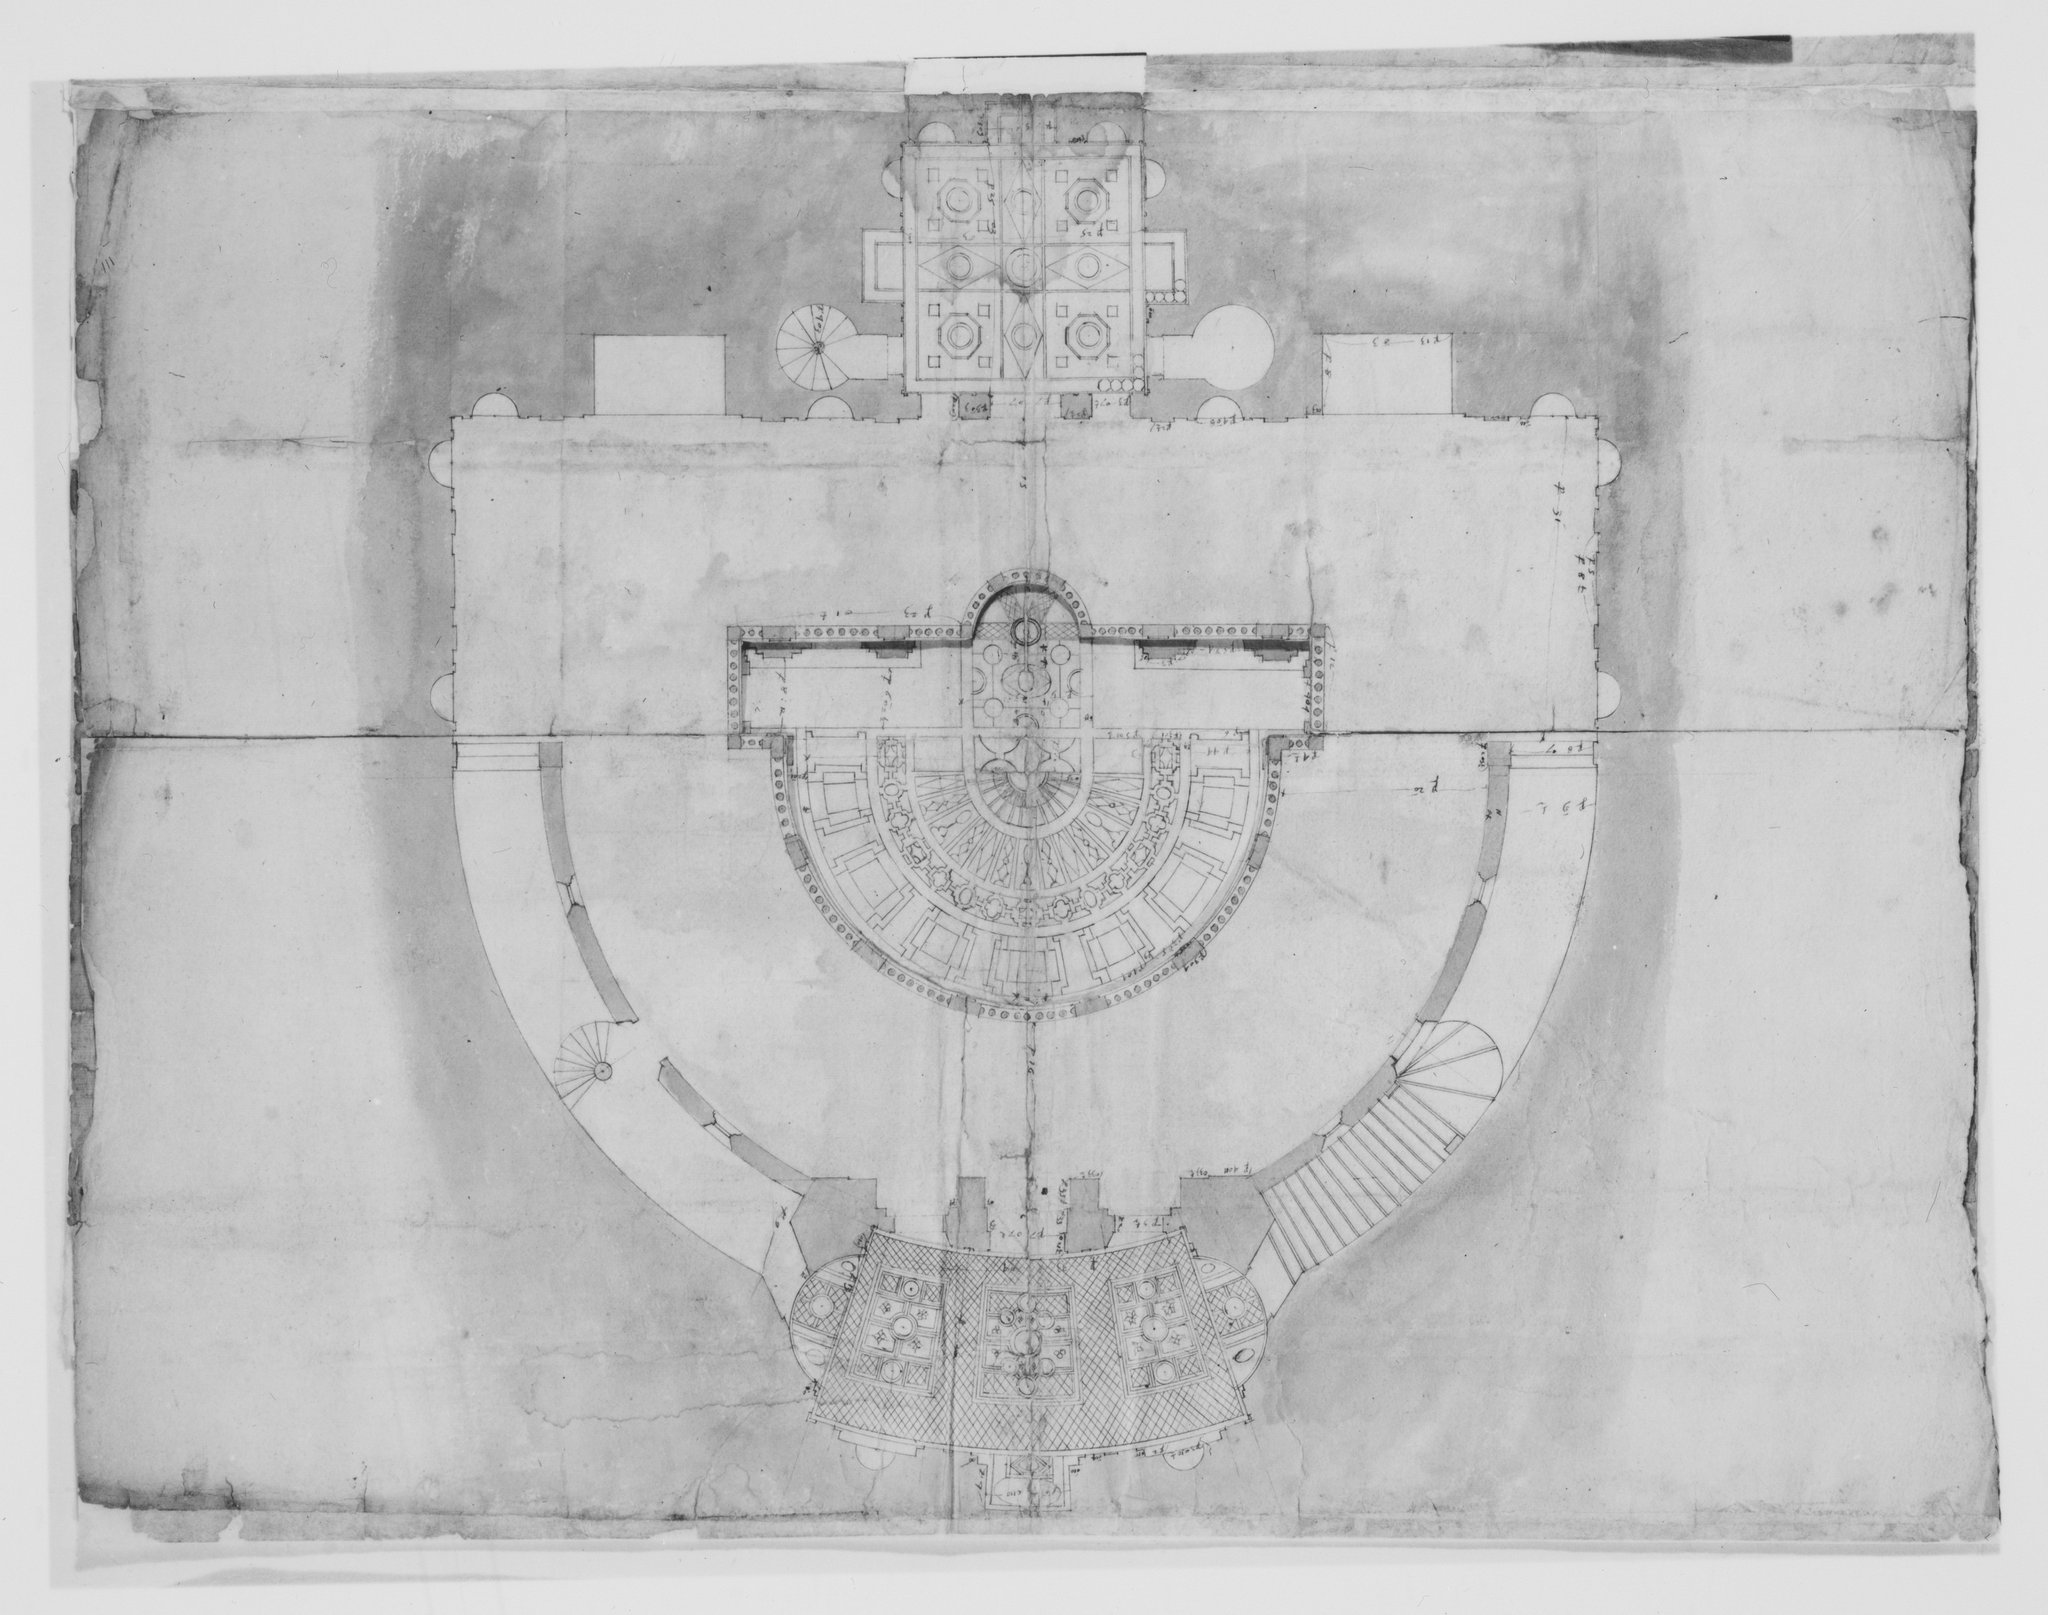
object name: drawing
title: Villa Giulia, plan (composite)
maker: anonymous, french, 16th century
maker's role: draftsman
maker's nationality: french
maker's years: 1500-1600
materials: chalk, ink, paper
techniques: brush, pen, wash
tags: architecture